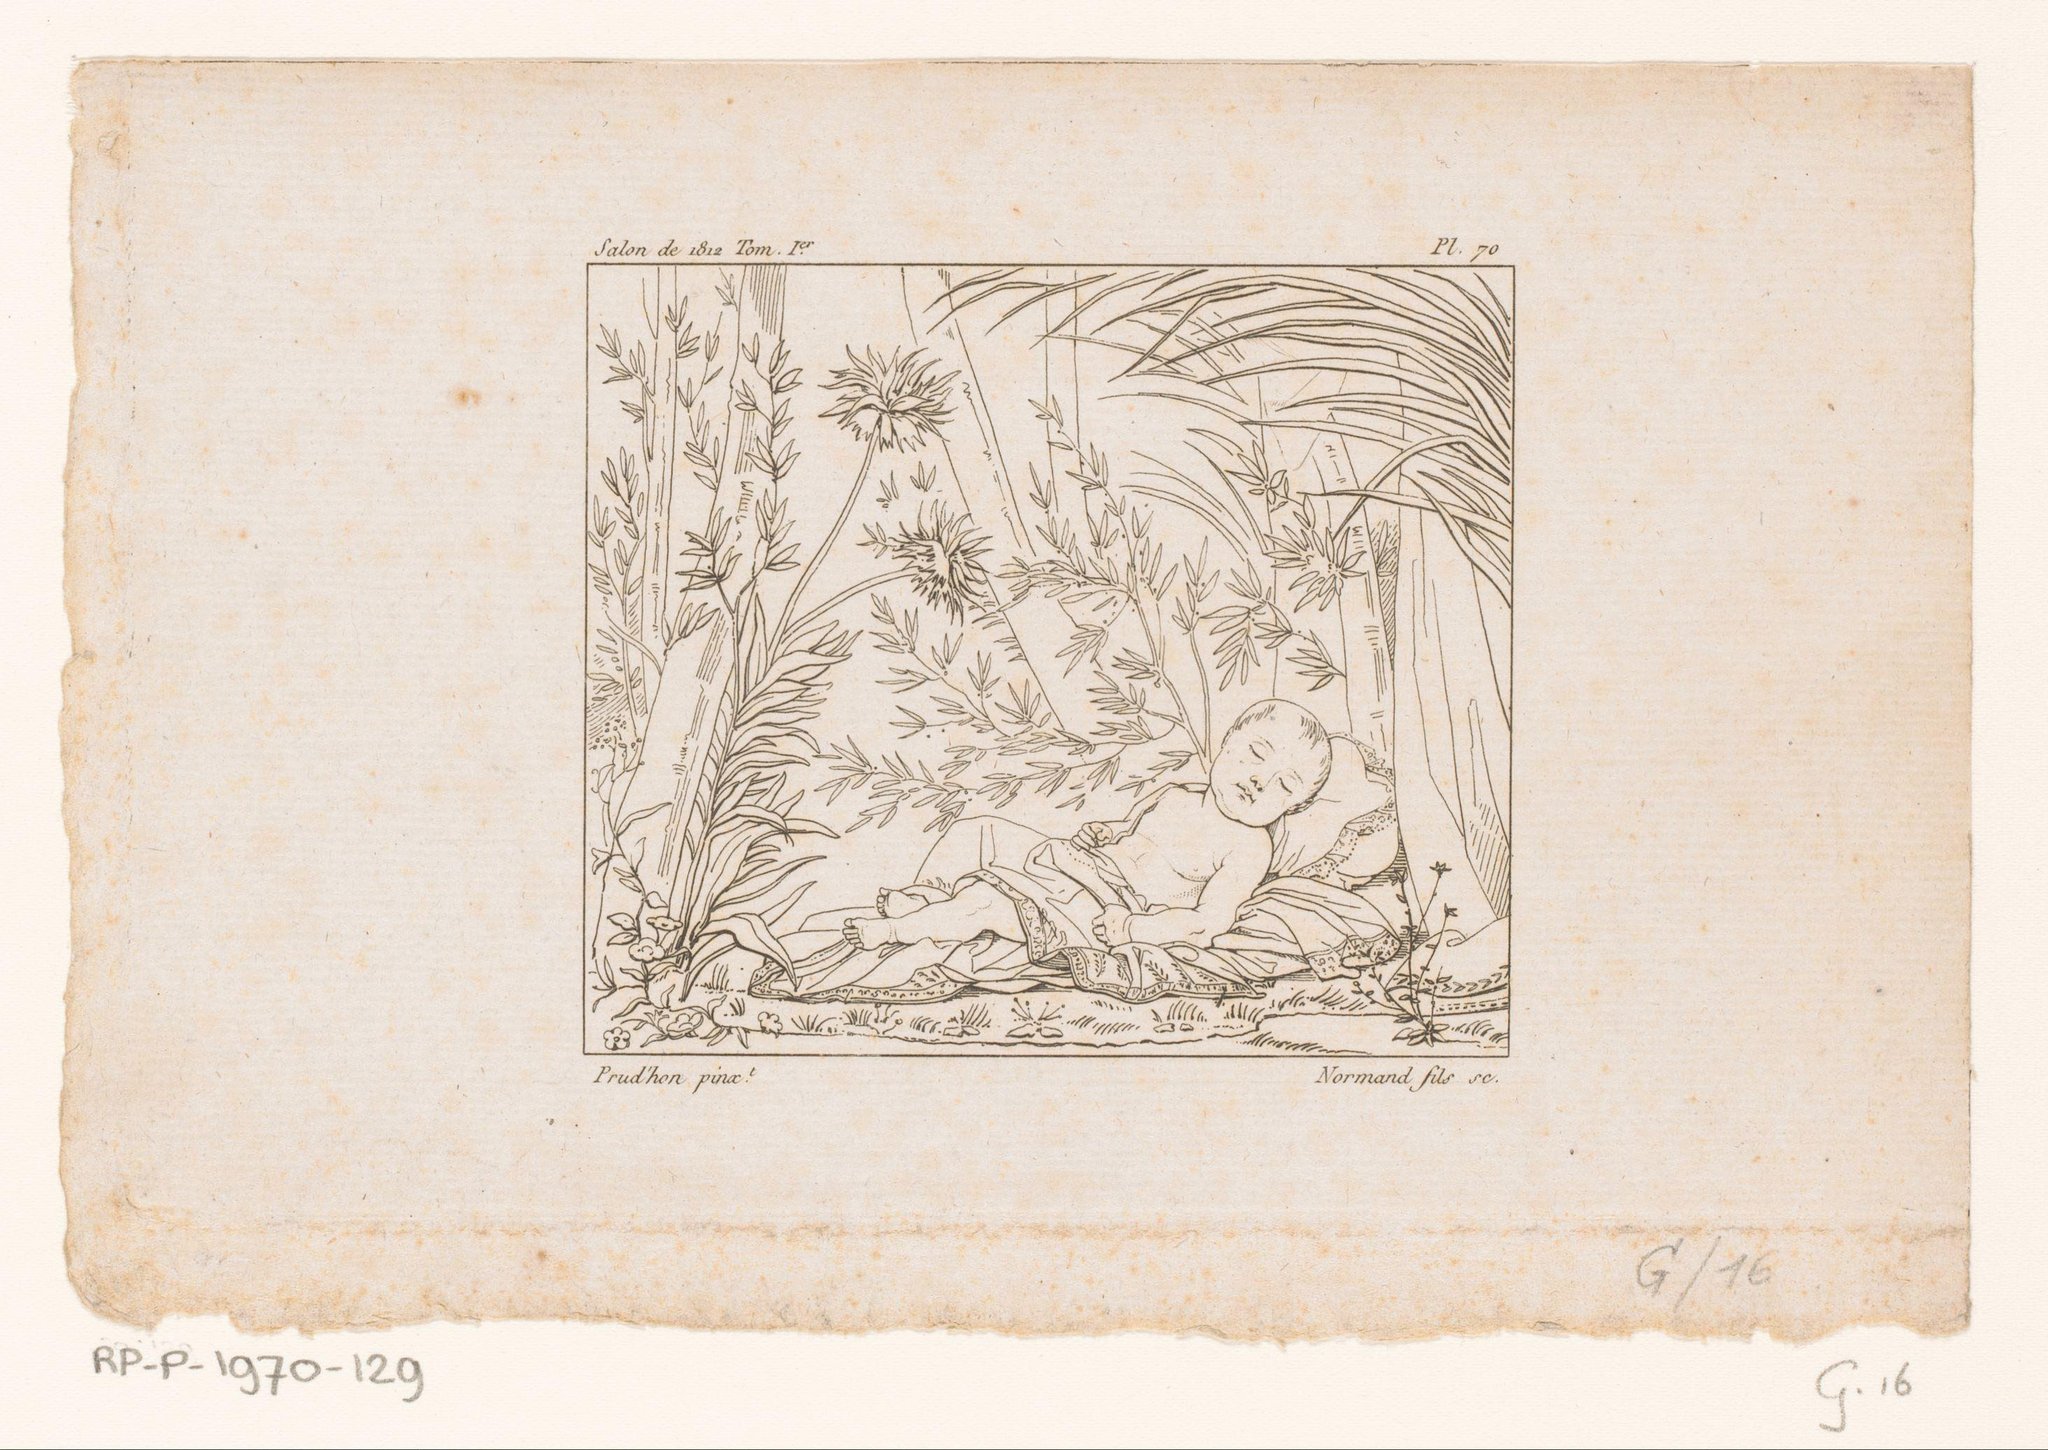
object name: print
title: Portret van Napoleon Frans Karel Jozef Bonaparte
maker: pierre prudhon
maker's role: draughtsman, painter, print maker, publisher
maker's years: 1758-1823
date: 1812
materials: paper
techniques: etching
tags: paris, vienna, historical persons, infant, baby, king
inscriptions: collector's mark: Lugt 2760, collector's mark: Lugt 2228a